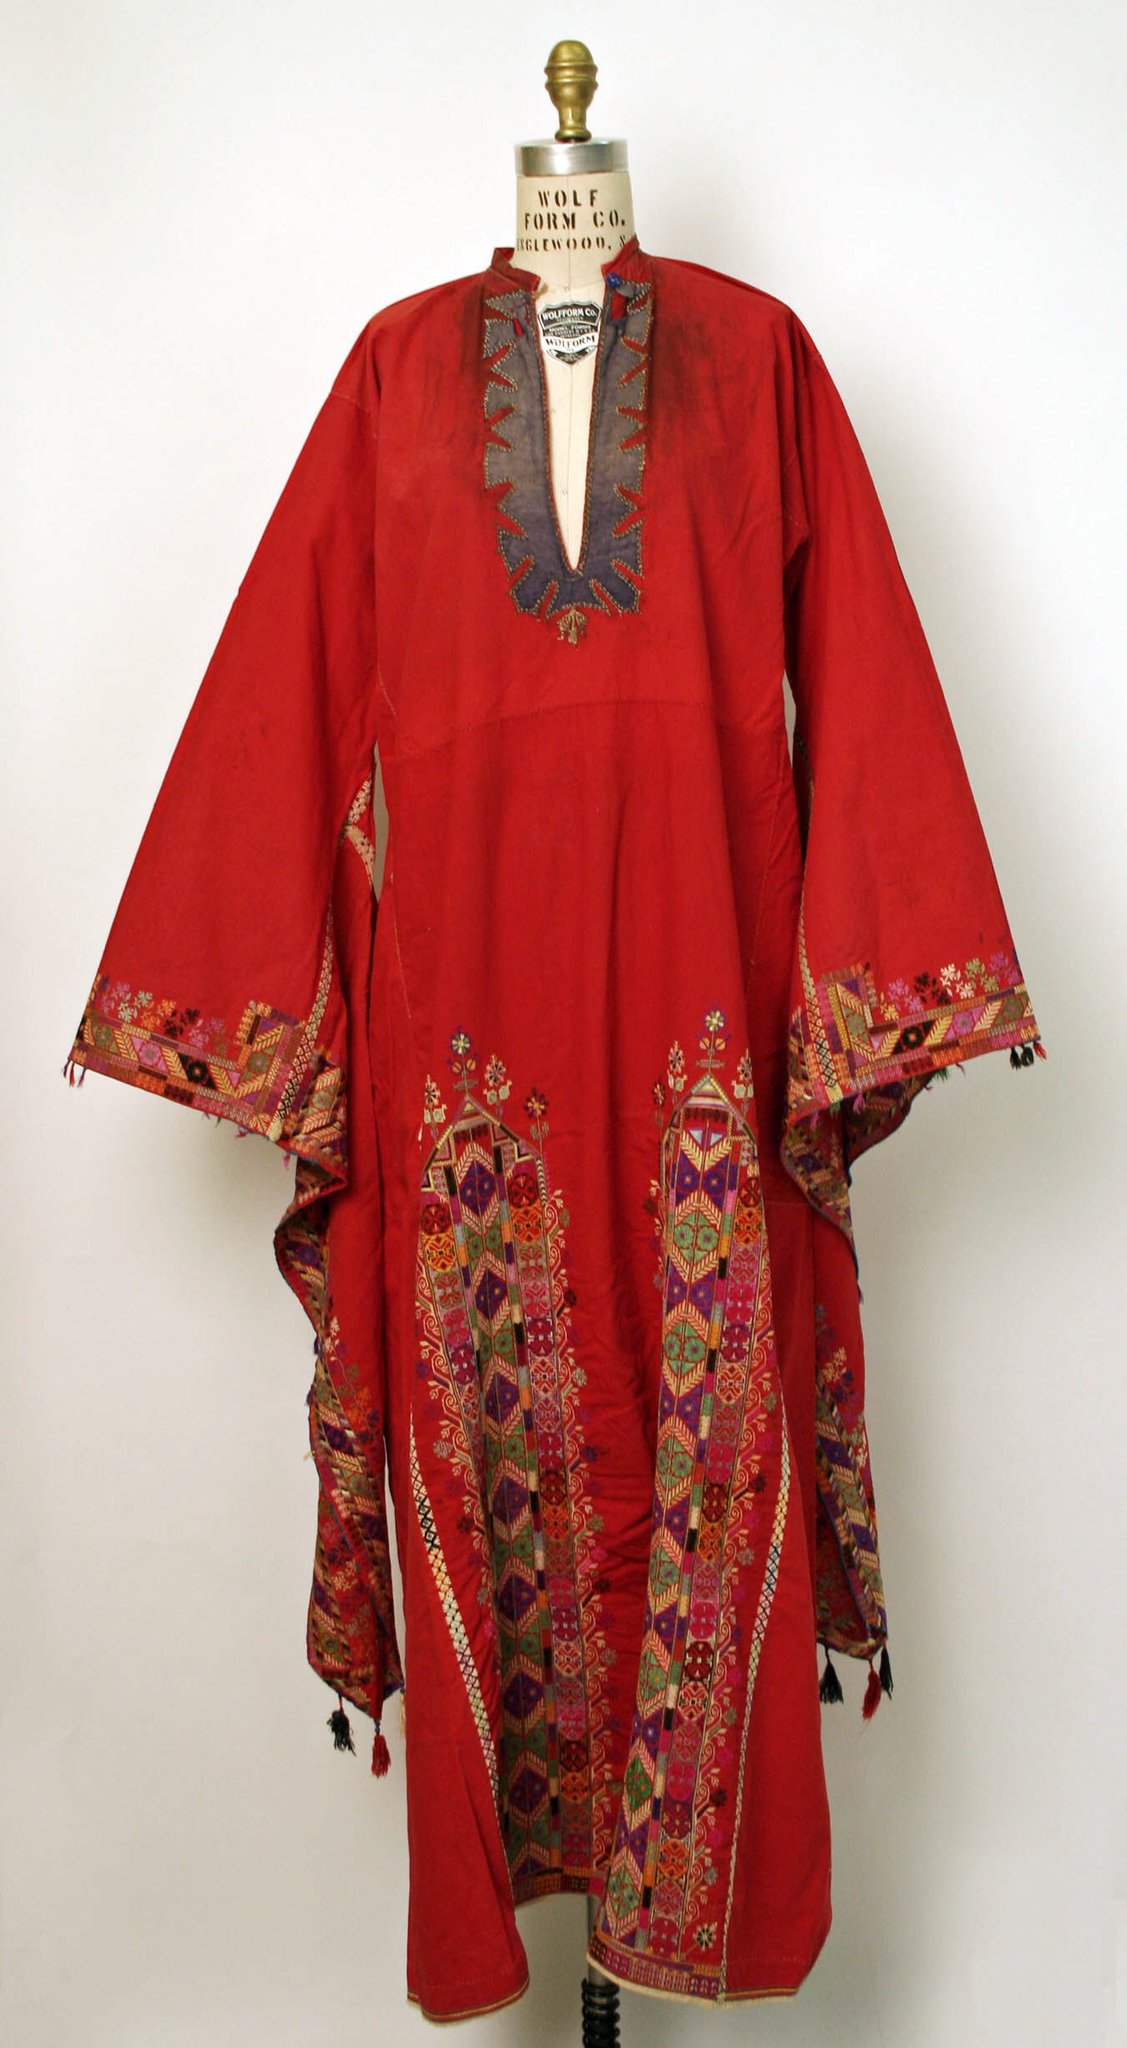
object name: dress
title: Festive Dress from Quteife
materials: cotton, silk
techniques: embroidery, weave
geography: syria